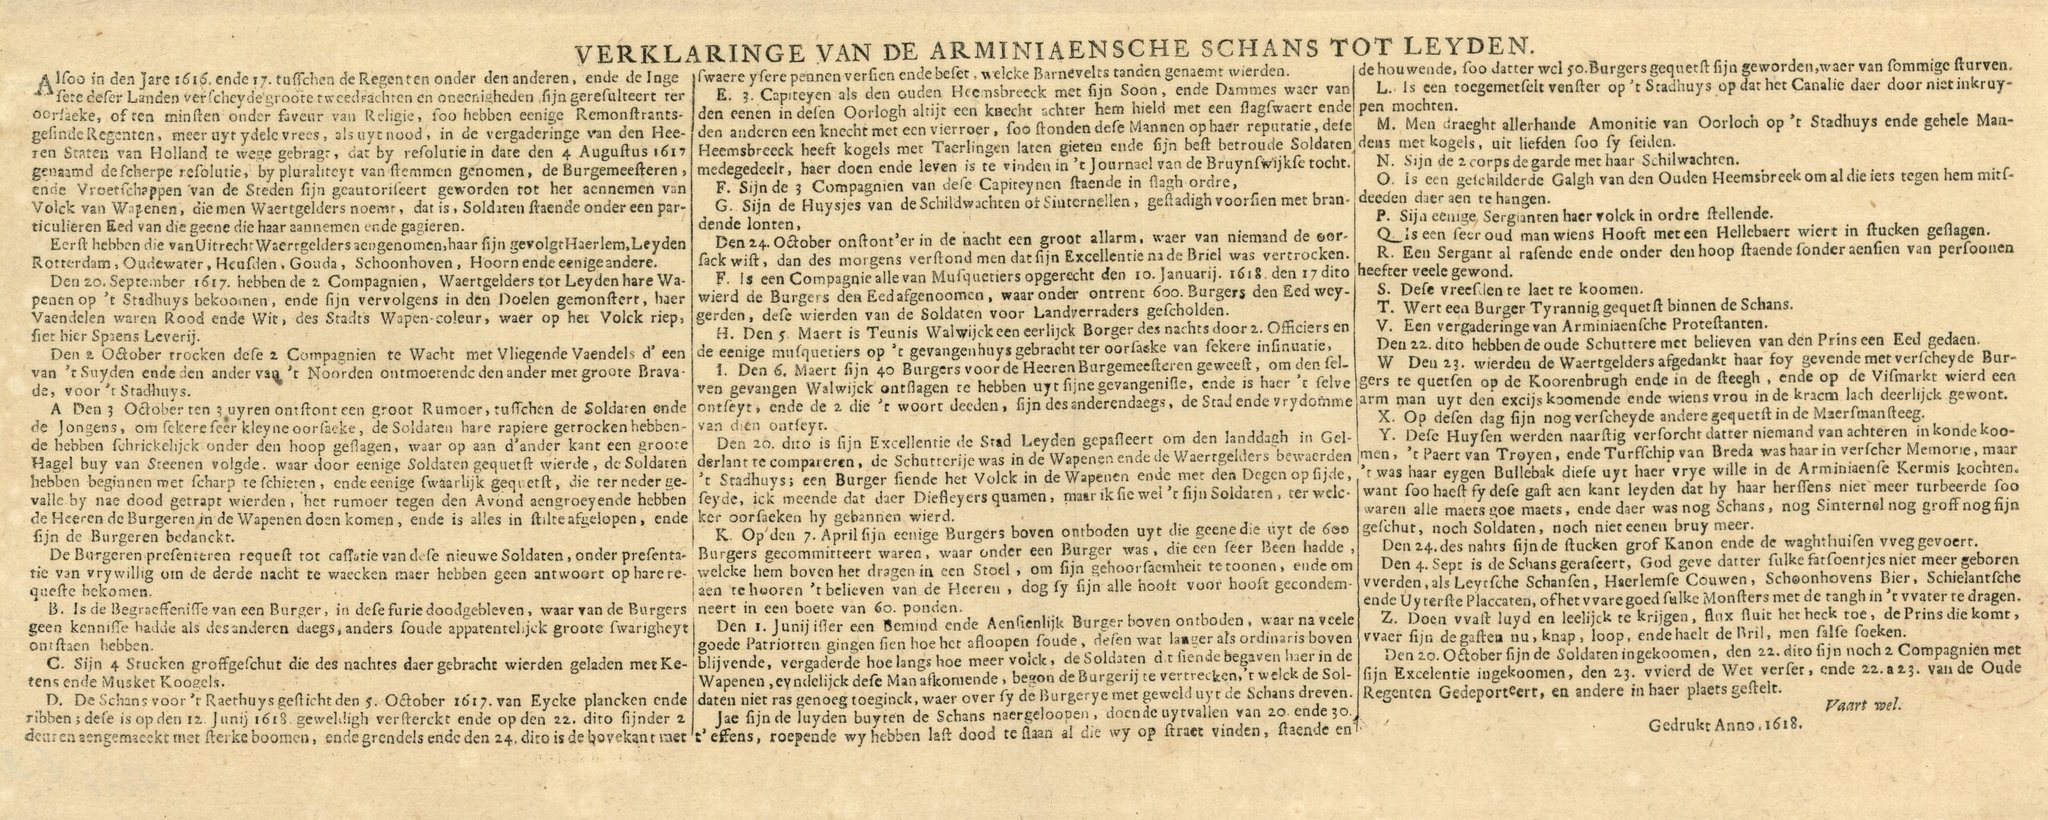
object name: text sheet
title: Verklaringe van de arminiaensche schans tot Leyden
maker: johannes tangena (16e en 17e eeuw)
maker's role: publisher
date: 1618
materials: paper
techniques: letterpress printing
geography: northern netherlands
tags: breestraat, arminiaanse schans te leiden, remonstranten en contraremonstranten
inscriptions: collector's mark: Lugt 240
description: Tekstblad behorend bij de voorstelling van de arminiaanse schans te Leiden. De schans werd op 5 oktober 1617 in de Breestraat bij het stadhuis opgericht om de remonstrants gezinde vroedschap en waardgelders te beschermen. Het blad behoort bij de heruitgave van de prent, die verscheen met de naam van de uitgever en de datering 1618. Het Nederlandse onderschrift is gedrukt over drie kolommen en geeft een beschrijving van de gebeurtenissen tot 20 oktober 1618 toen de schans is afgebroken en een verklaring van de letters in de voorstelling (zie RP-P-OB-77.267).